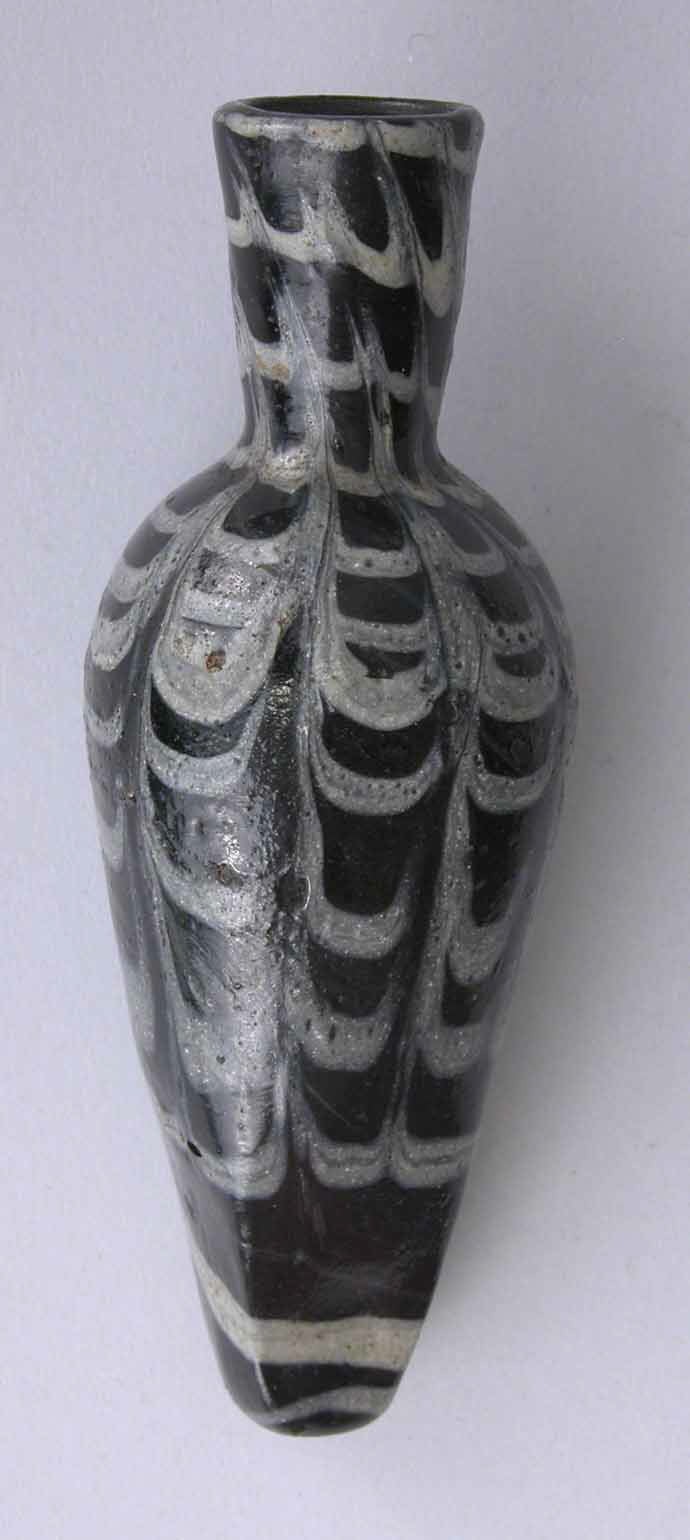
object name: bottle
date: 901-1100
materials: glass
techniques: glassblowing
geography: egypt